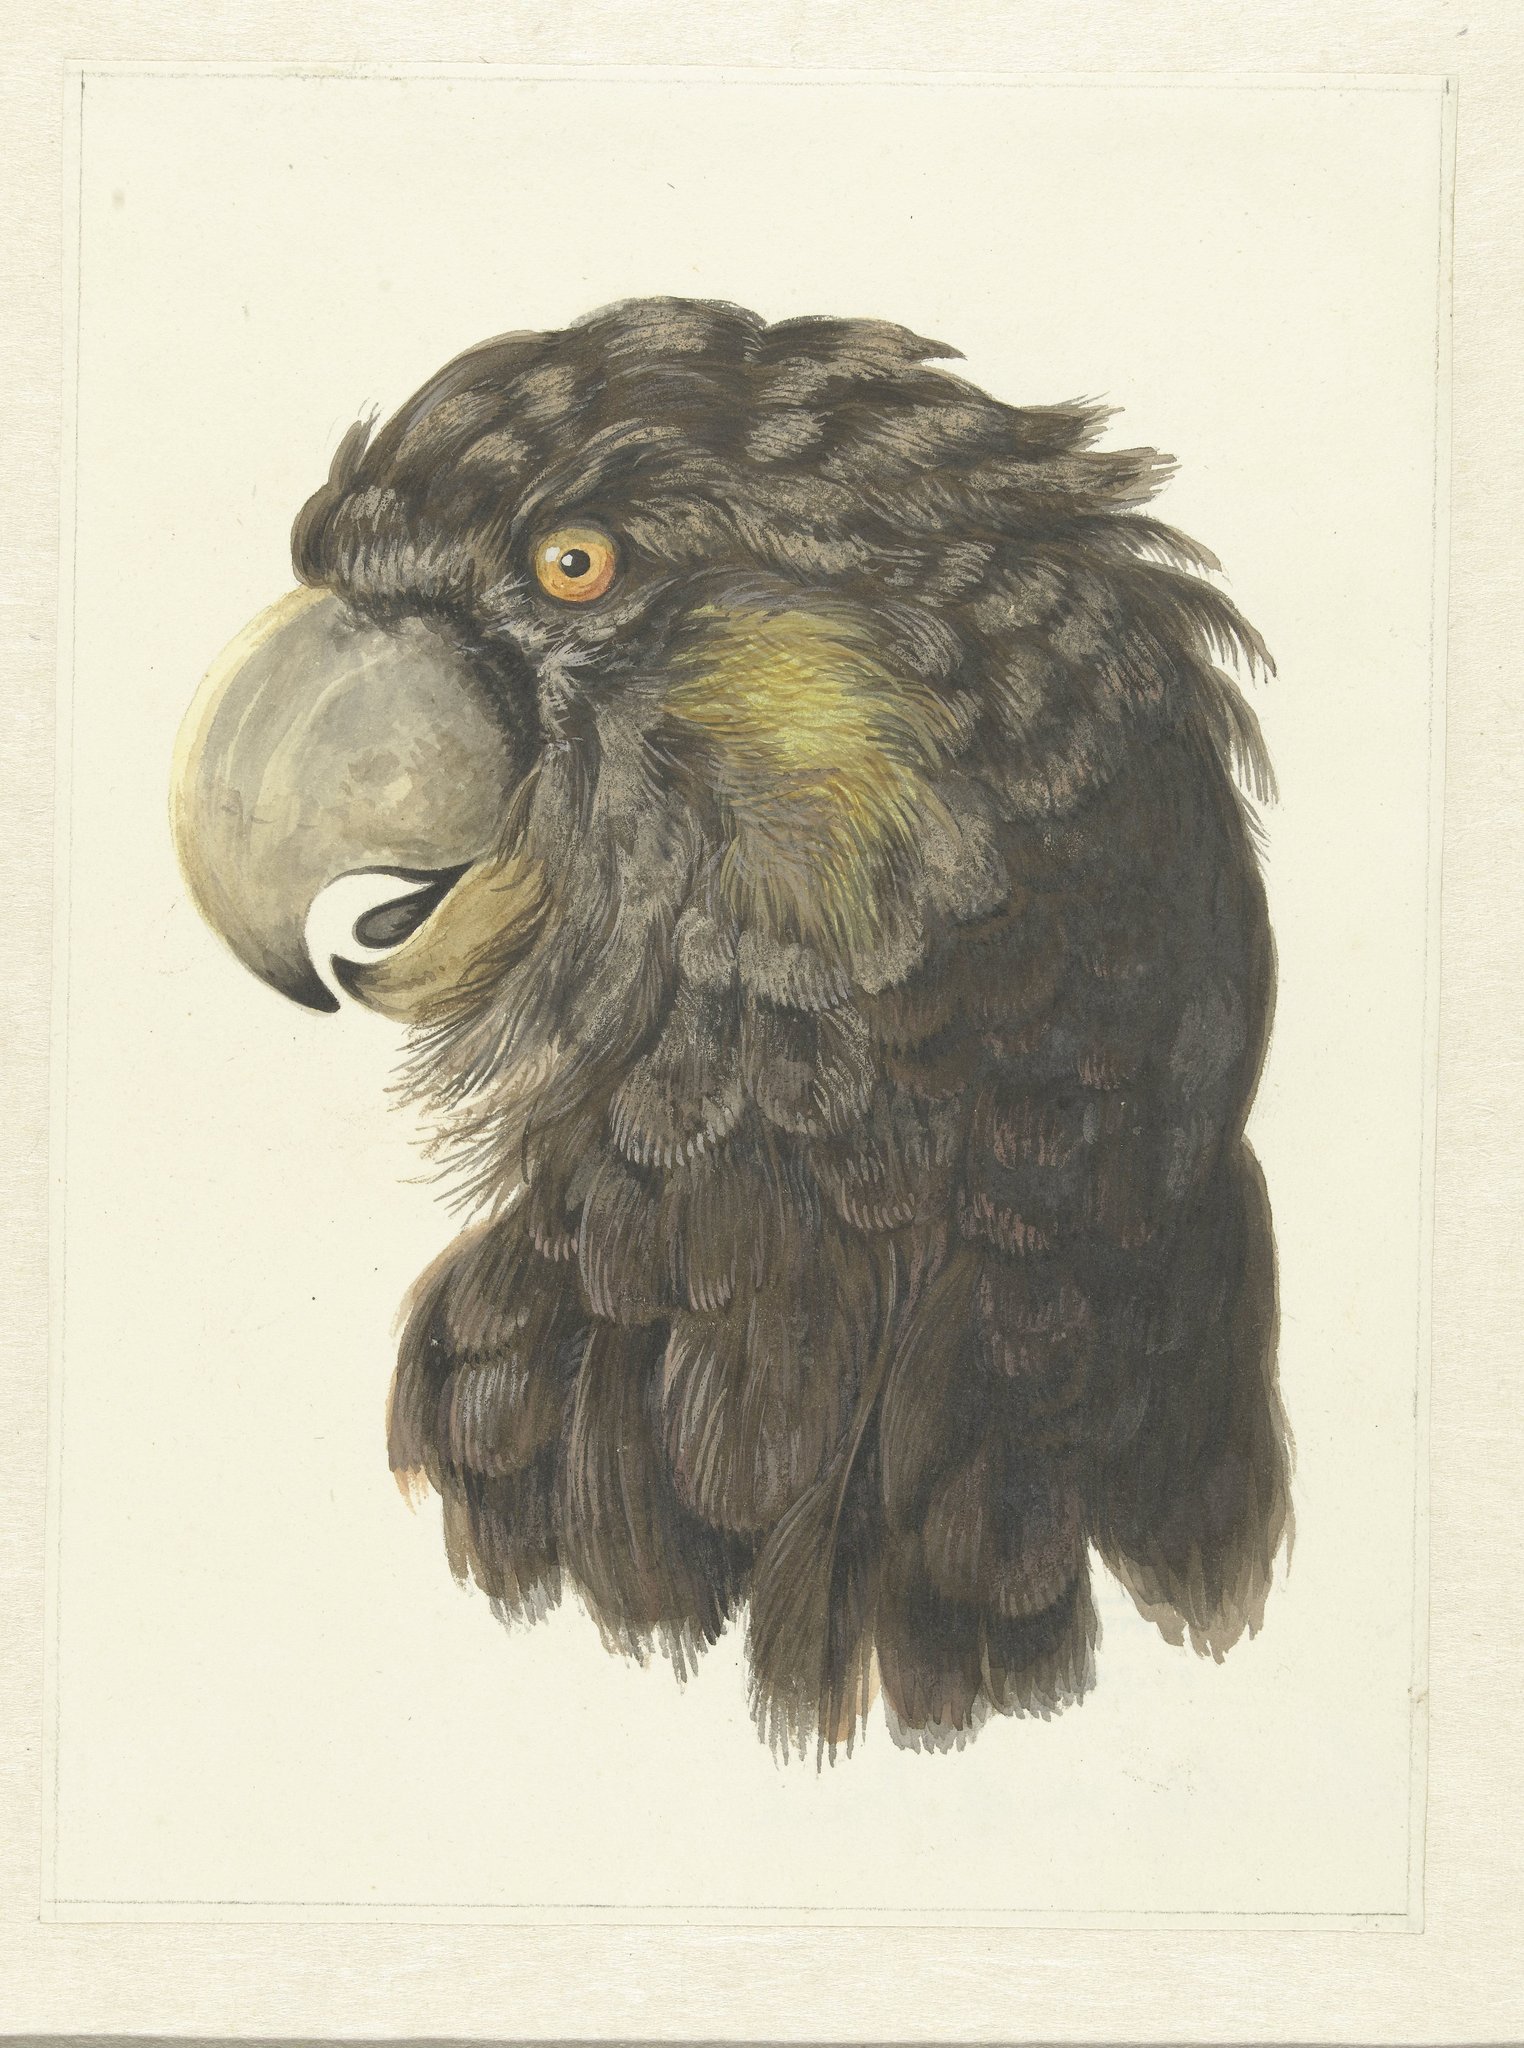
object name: drawing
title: Head of a Cockatoo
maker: aert schouman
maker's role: draughtsman, painter, print maker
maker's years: 1710-1792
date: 1725-1792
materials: paper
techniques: aquarelle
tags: ornamental birds: cockatoo, australia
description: RP-T-1905-220 t/m 254: Vijfendertig Tekeningen met verschillende vogel- en apensoorten. Op één ervan: Histoire naturelle de viseaux d'Afrique par Francóis Le voillant Exemple. soignees.